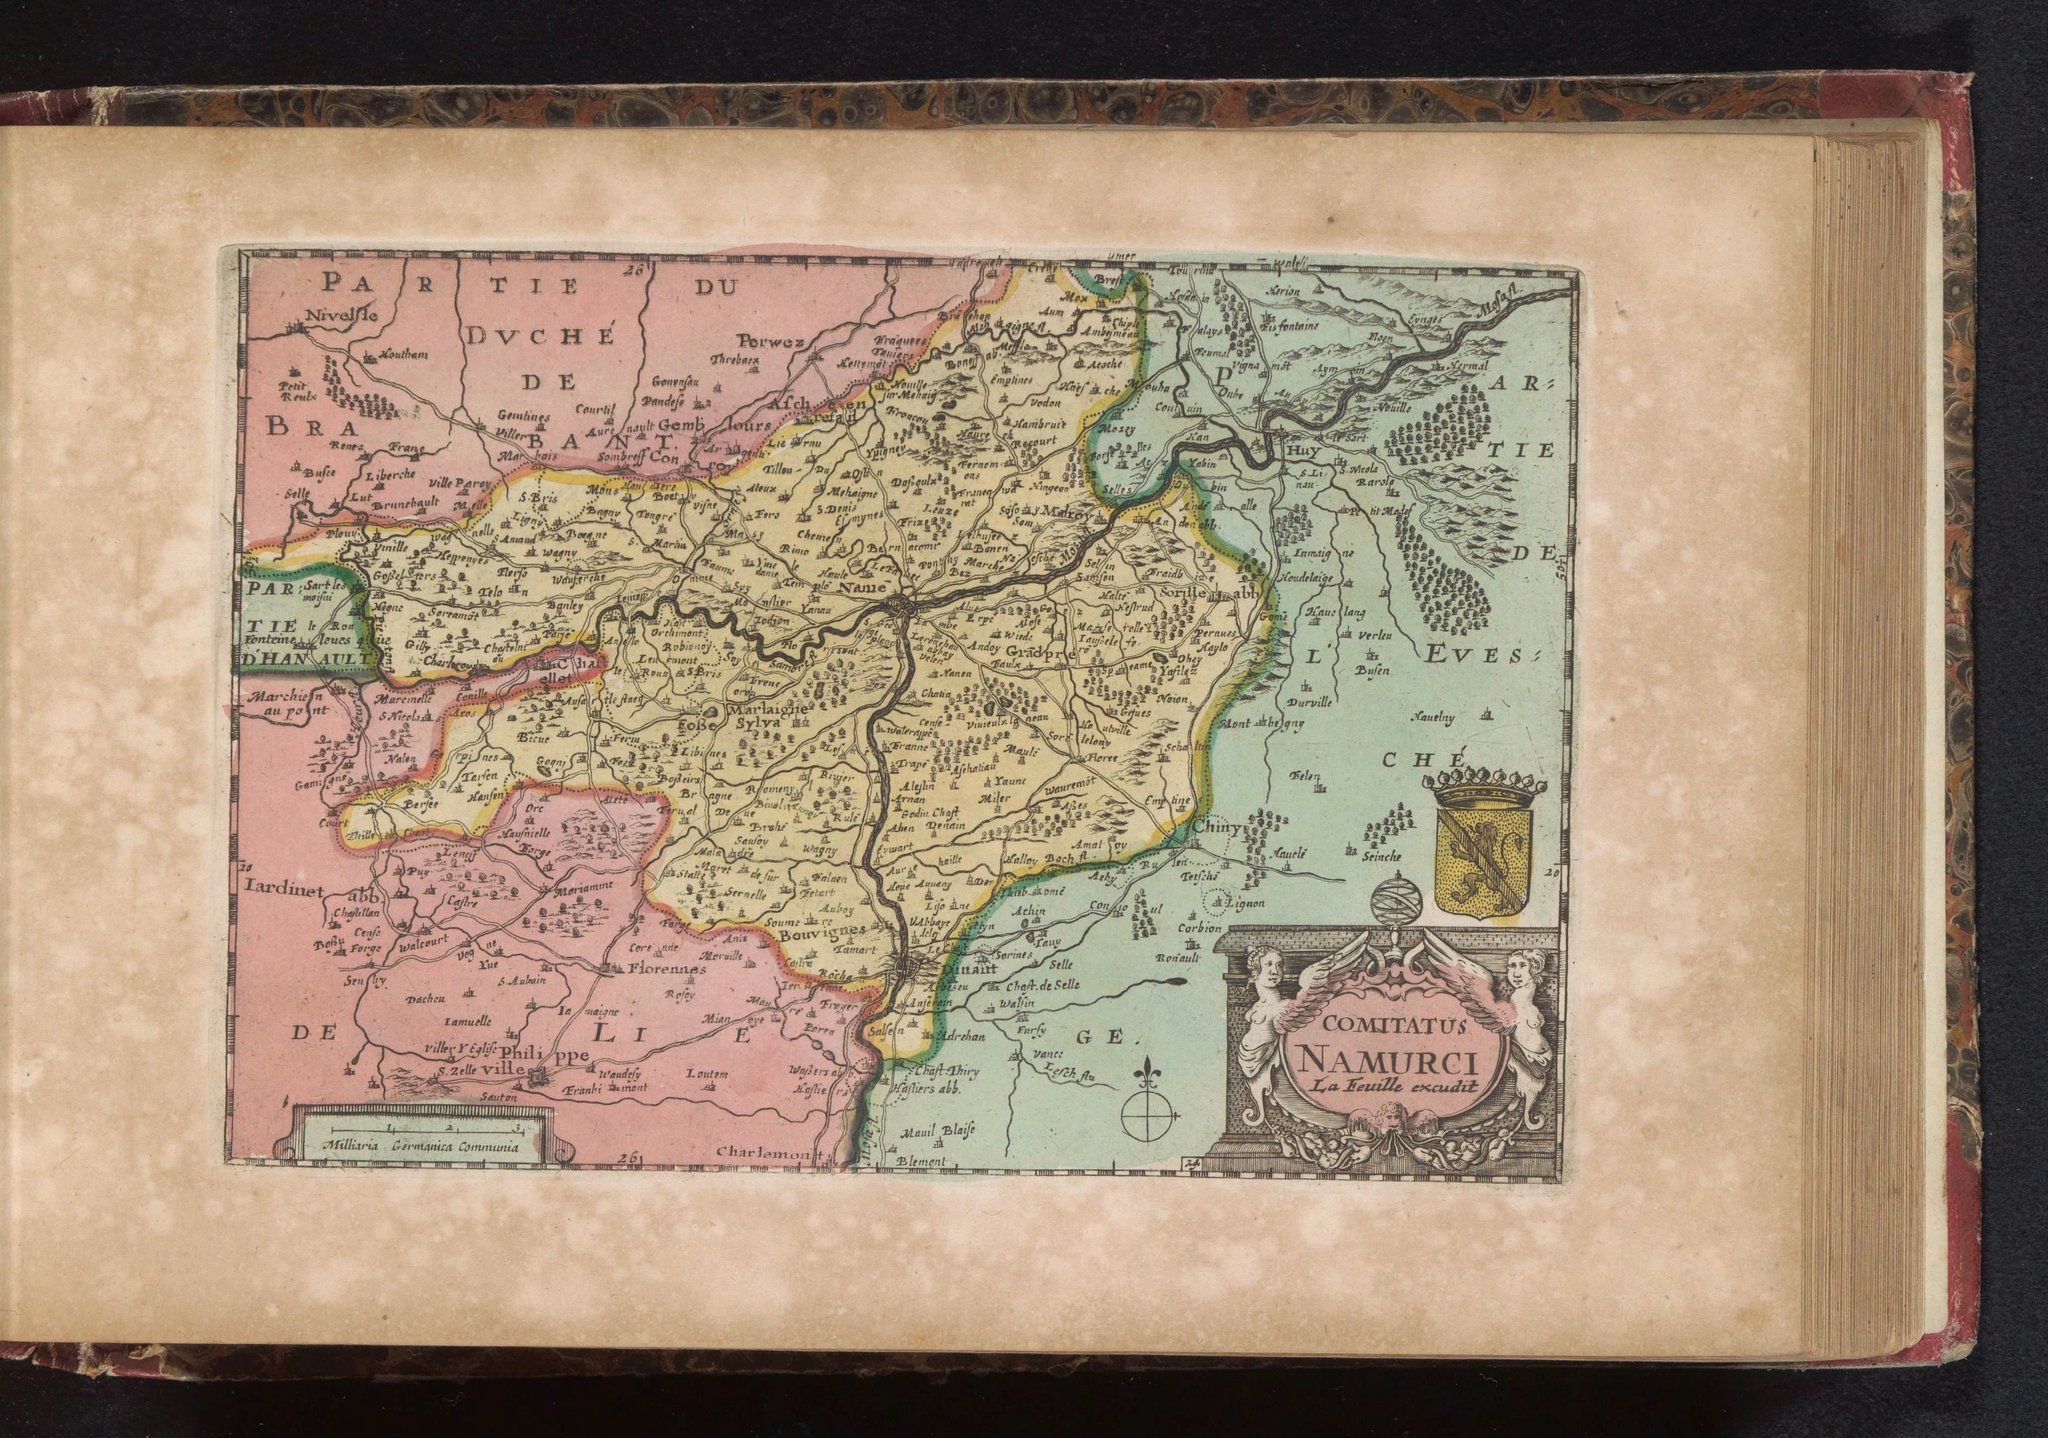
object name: print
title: Kaart van Namen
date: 1700-1702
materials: paper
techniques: engraving, hand coloring, lacquer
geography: northern netherlands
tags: maps of separate countries or regions, namur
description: Kaart van het graafschap Namen. Onderdeel van een atlas met 223 kaarten van landen en steden en oorlogstaferelen in Europa in de periode ca. 1690-1735.